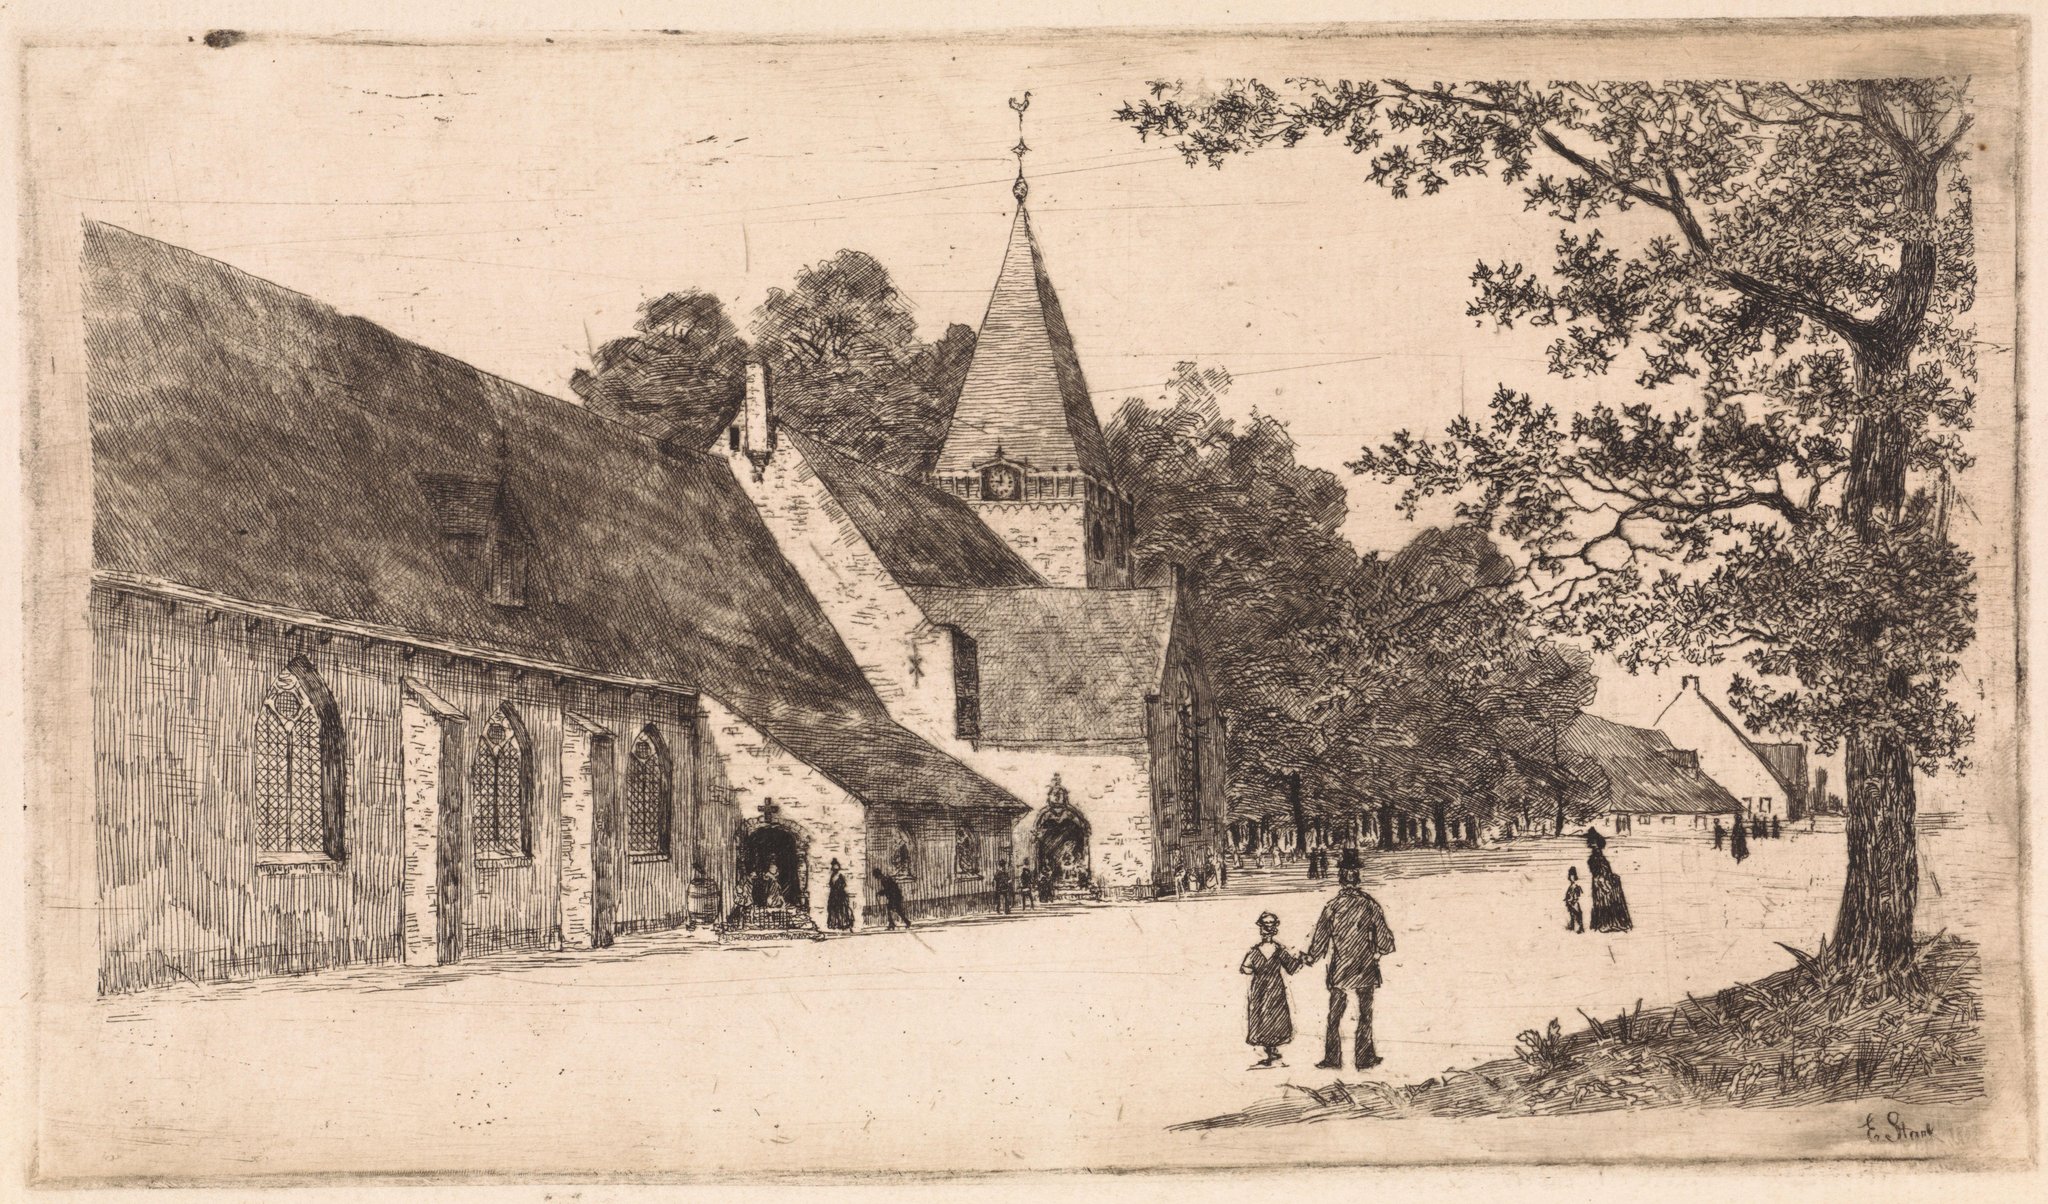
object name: print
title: Grote Kerk te Vreeland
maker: elias stark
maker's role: draughtsman, print maker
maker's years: 1849-1933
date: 1887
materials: paper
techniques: etching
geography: nieuwer-amstel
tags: church (exterior)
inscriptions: collector's mark: Lugt 2228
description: De Grote of Sint Nicolaaskerk te Vreeland.